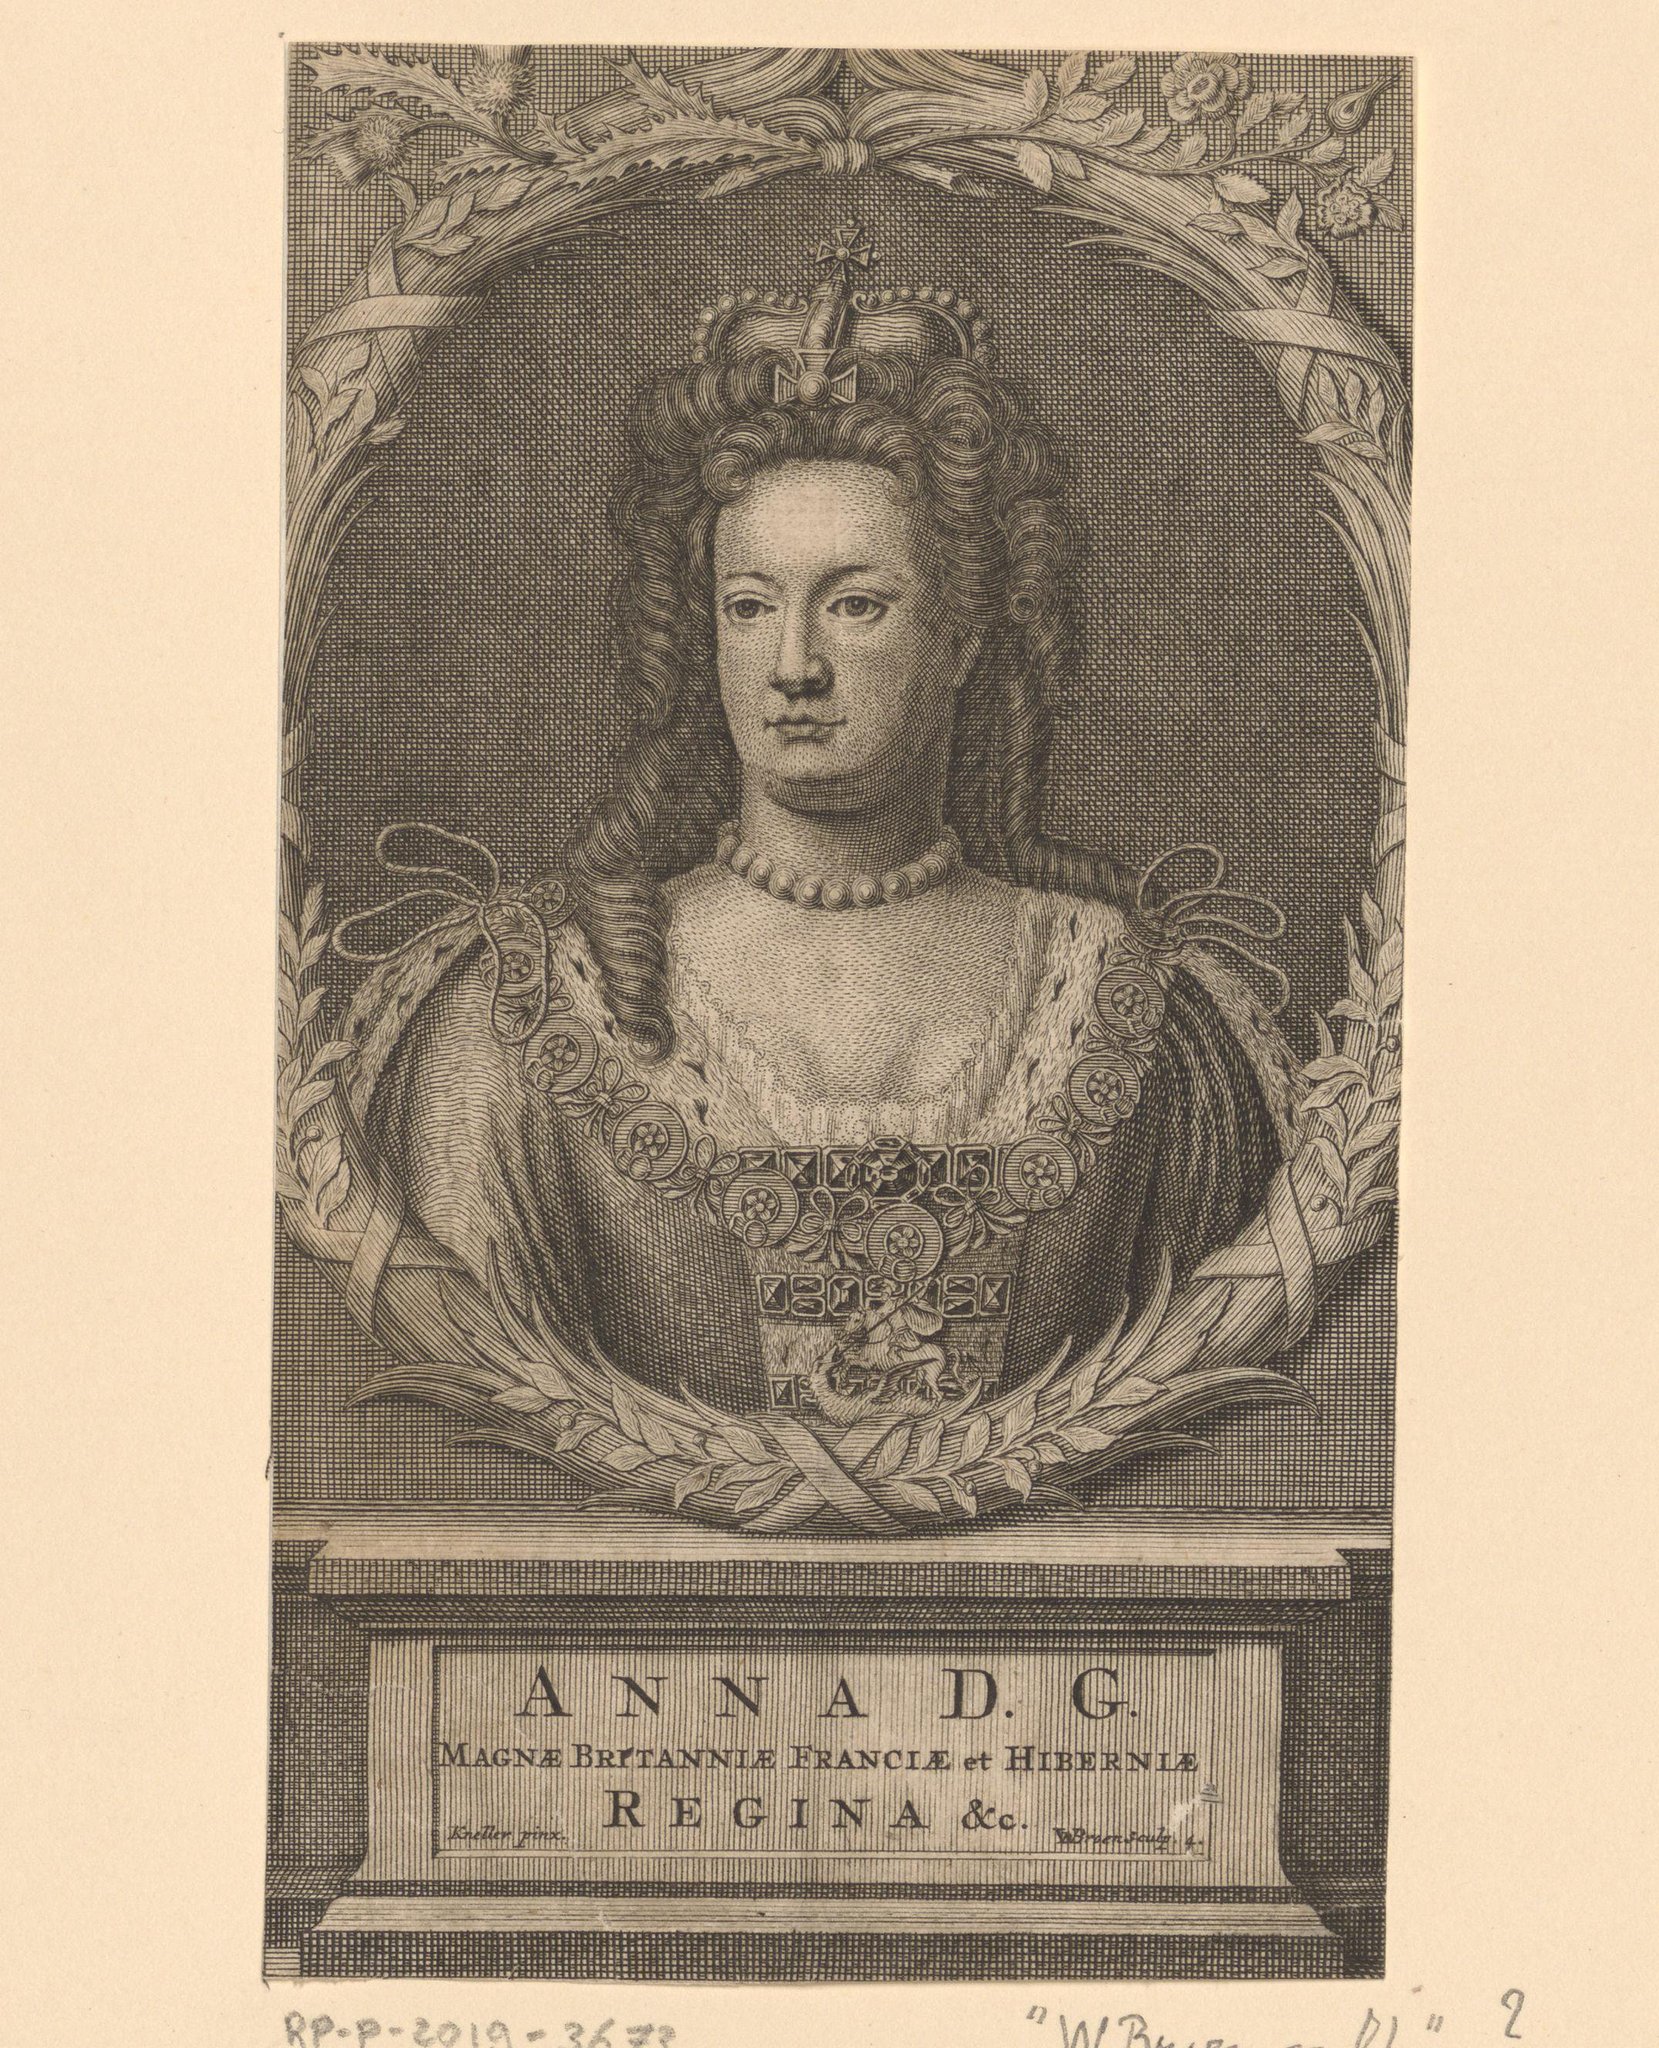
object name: print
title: Portret van Anna Stuart, koningin van Groot-Brittannië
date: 1707-1748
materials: paper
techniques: engraving, etching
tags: anna stuart (koningin van engeland en schotland), historical persons - bb - woman